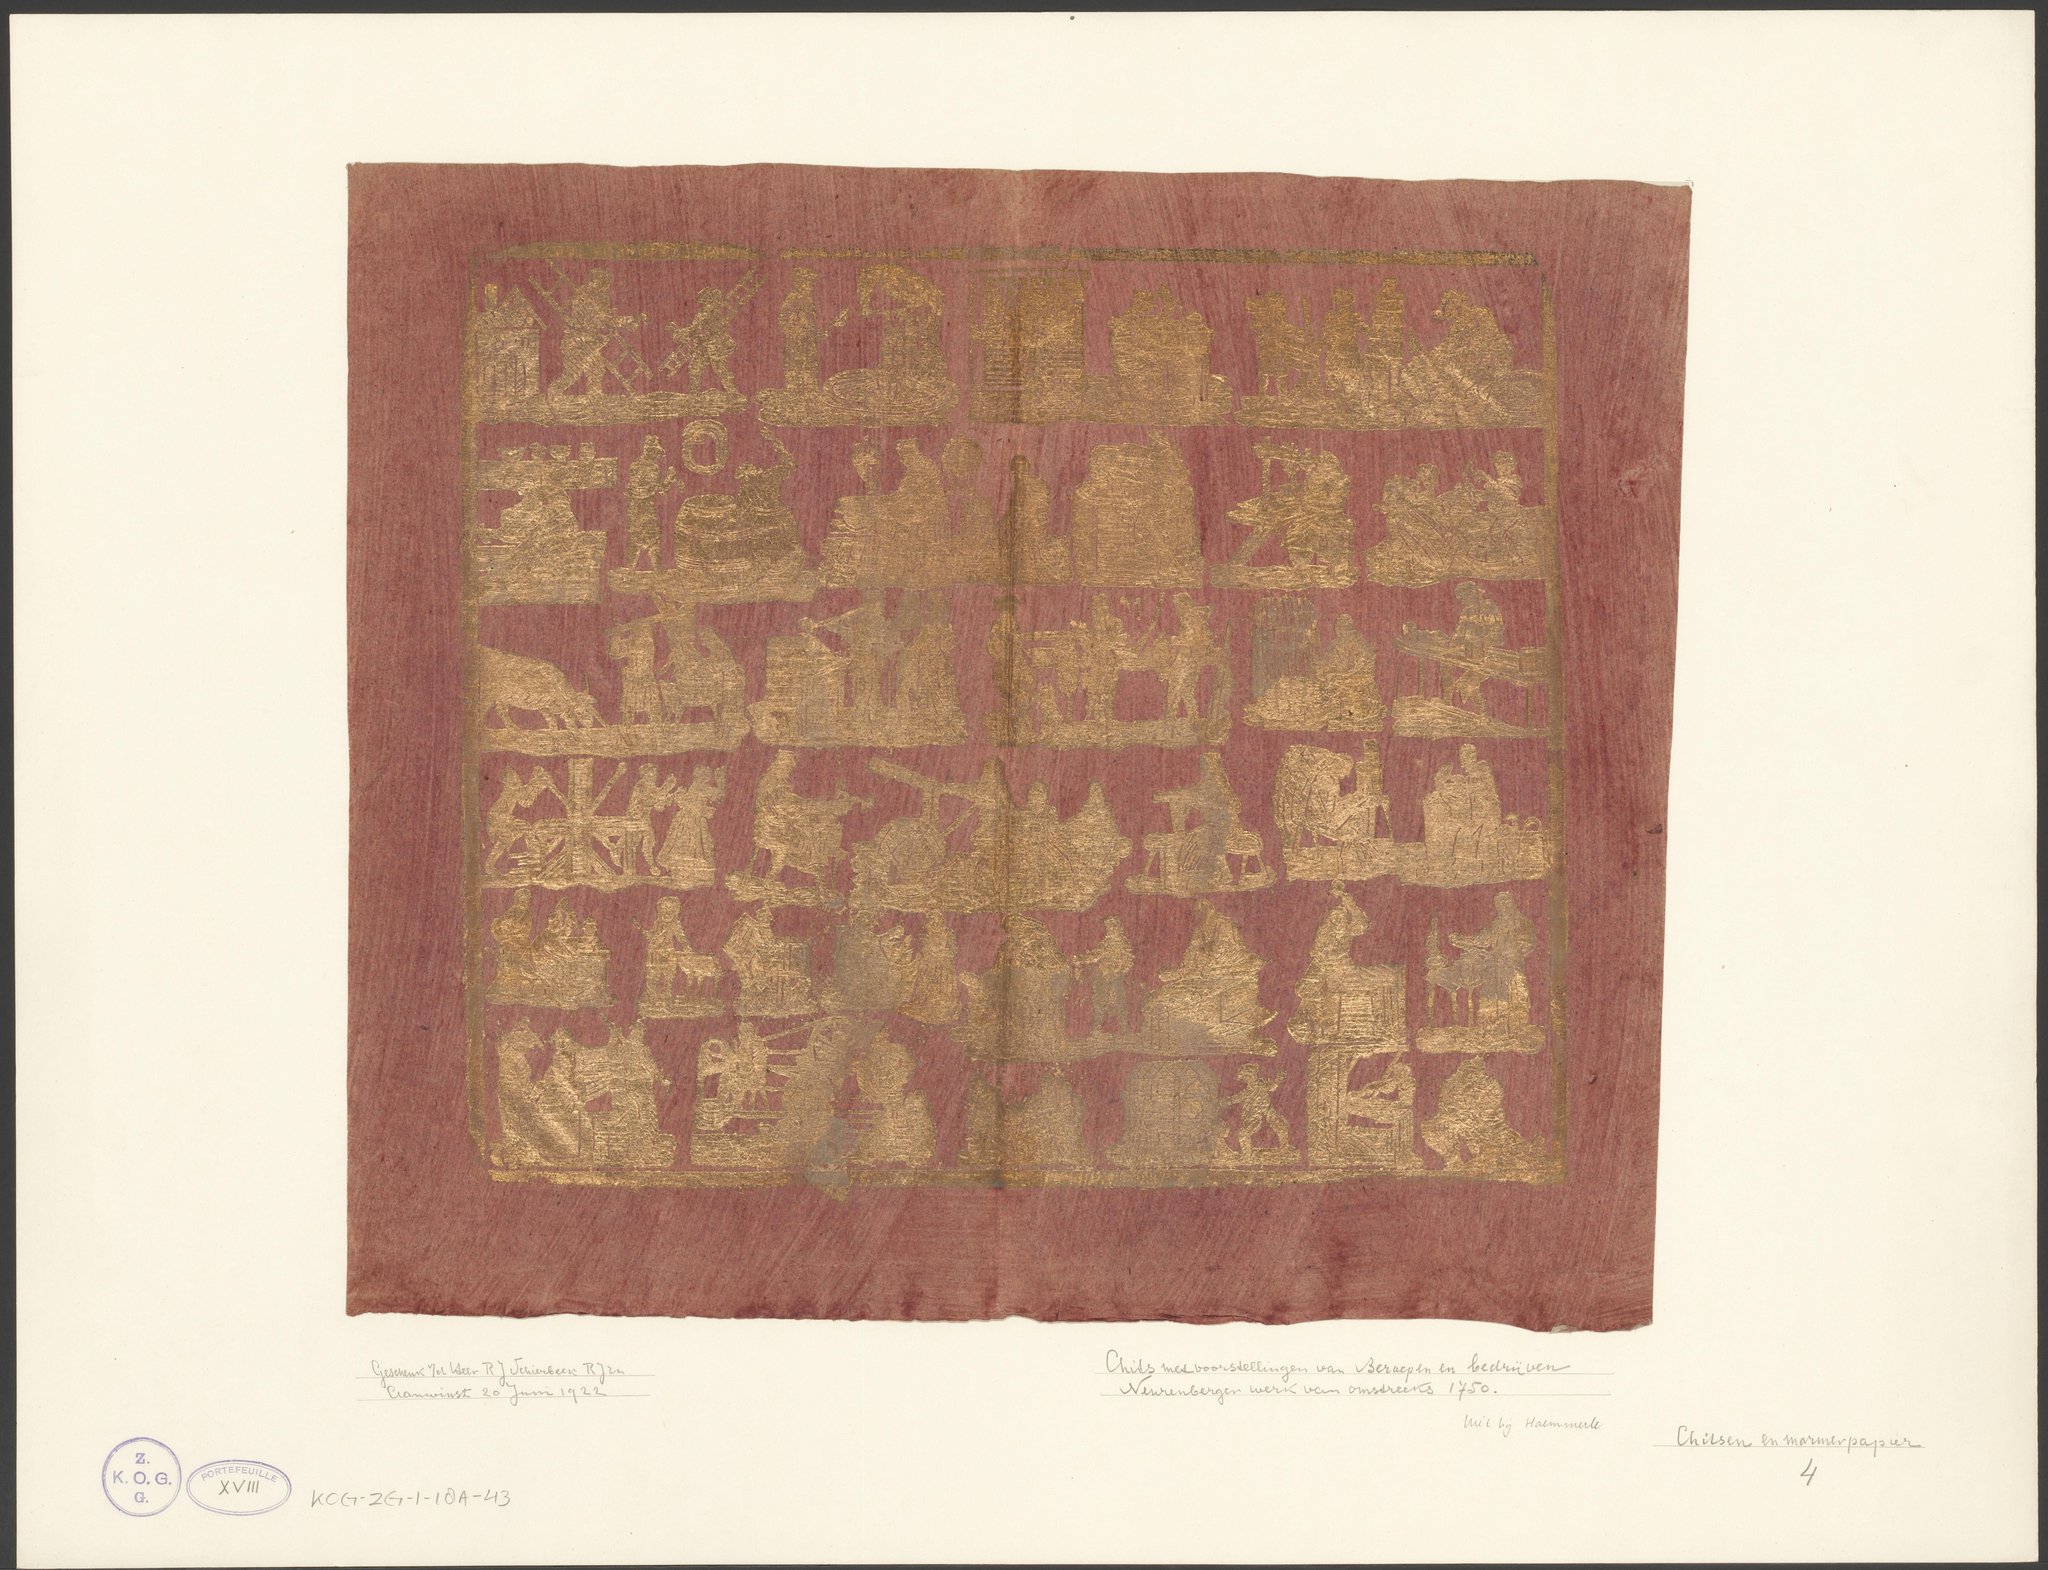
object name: brocade paper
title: Blad met patroon van verschillende beroepen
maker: Anonymous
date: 1750-1800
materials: gold leaf, paint, paper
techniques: relief print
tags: handicrafts, craftsman at work, birds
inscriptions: stamp, collector's mark: Lugt 1641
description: Sierpapier met een patroon van verschillende beroepen. Onderwerpsrubrieken binnen de Atlas Zeden en Gewoonten: Schoone kunsten, Sitsen en marmerpapier.